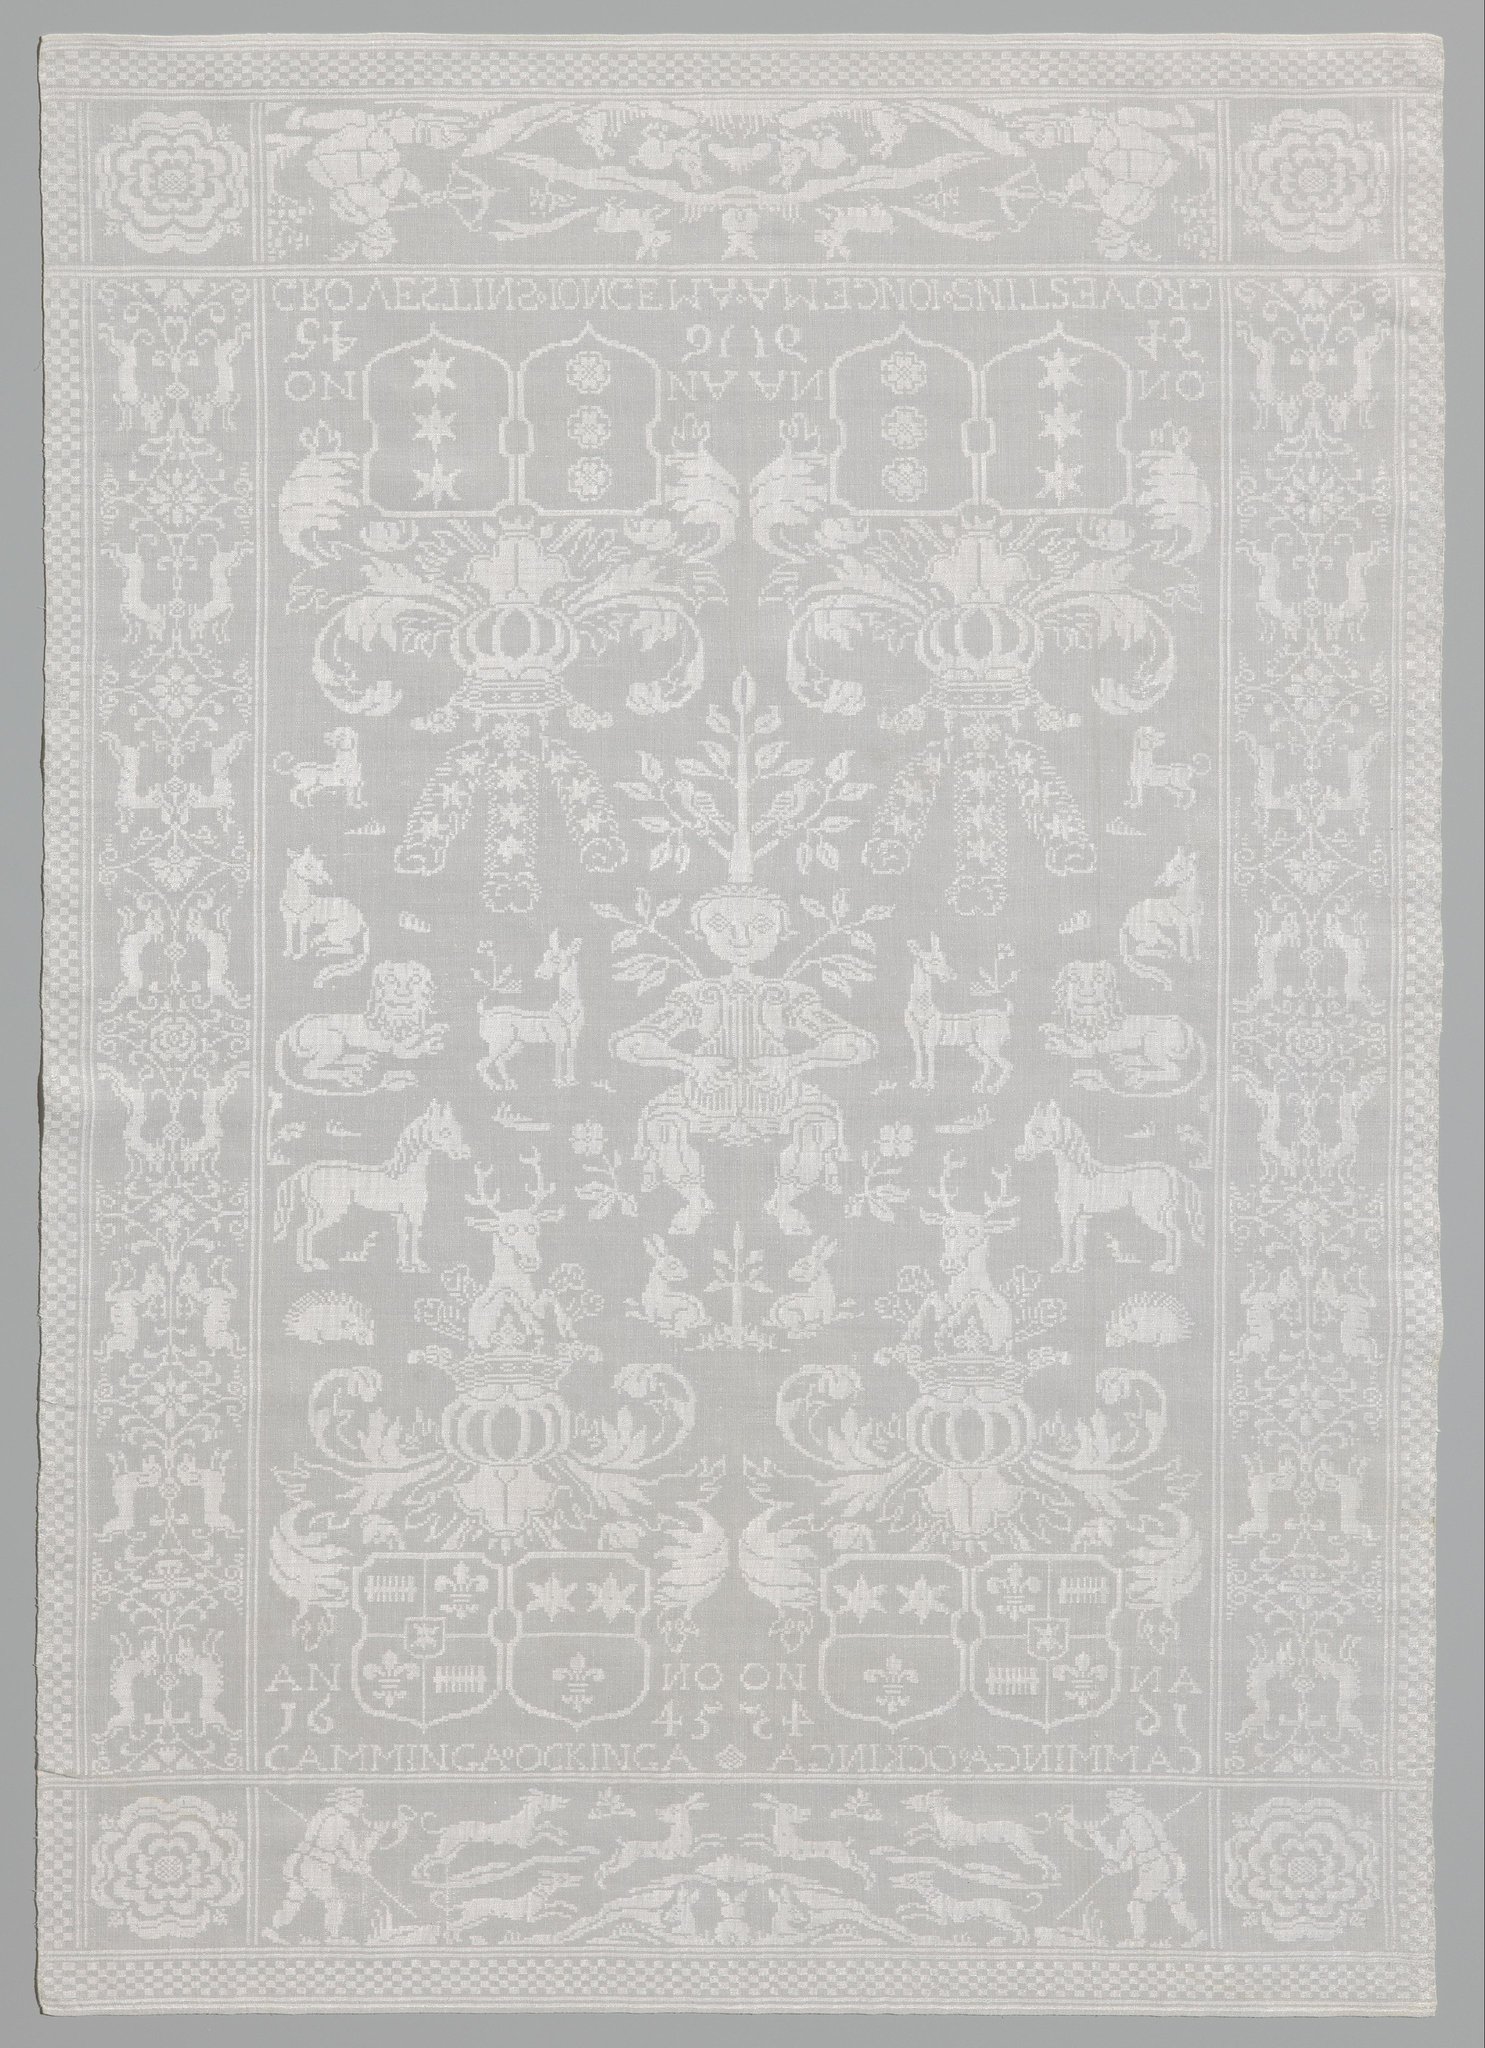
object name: napkin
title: Servet met Friese wapens en Orpheus te midden van de dieren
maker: quirijn jansz. damast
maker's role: mayor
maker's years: 1580-1638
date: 1645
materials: linen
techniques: damask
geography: haarlem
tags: orpheus playing the lyre: trees and rocks move, beasts and birds are enchanted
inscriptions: date